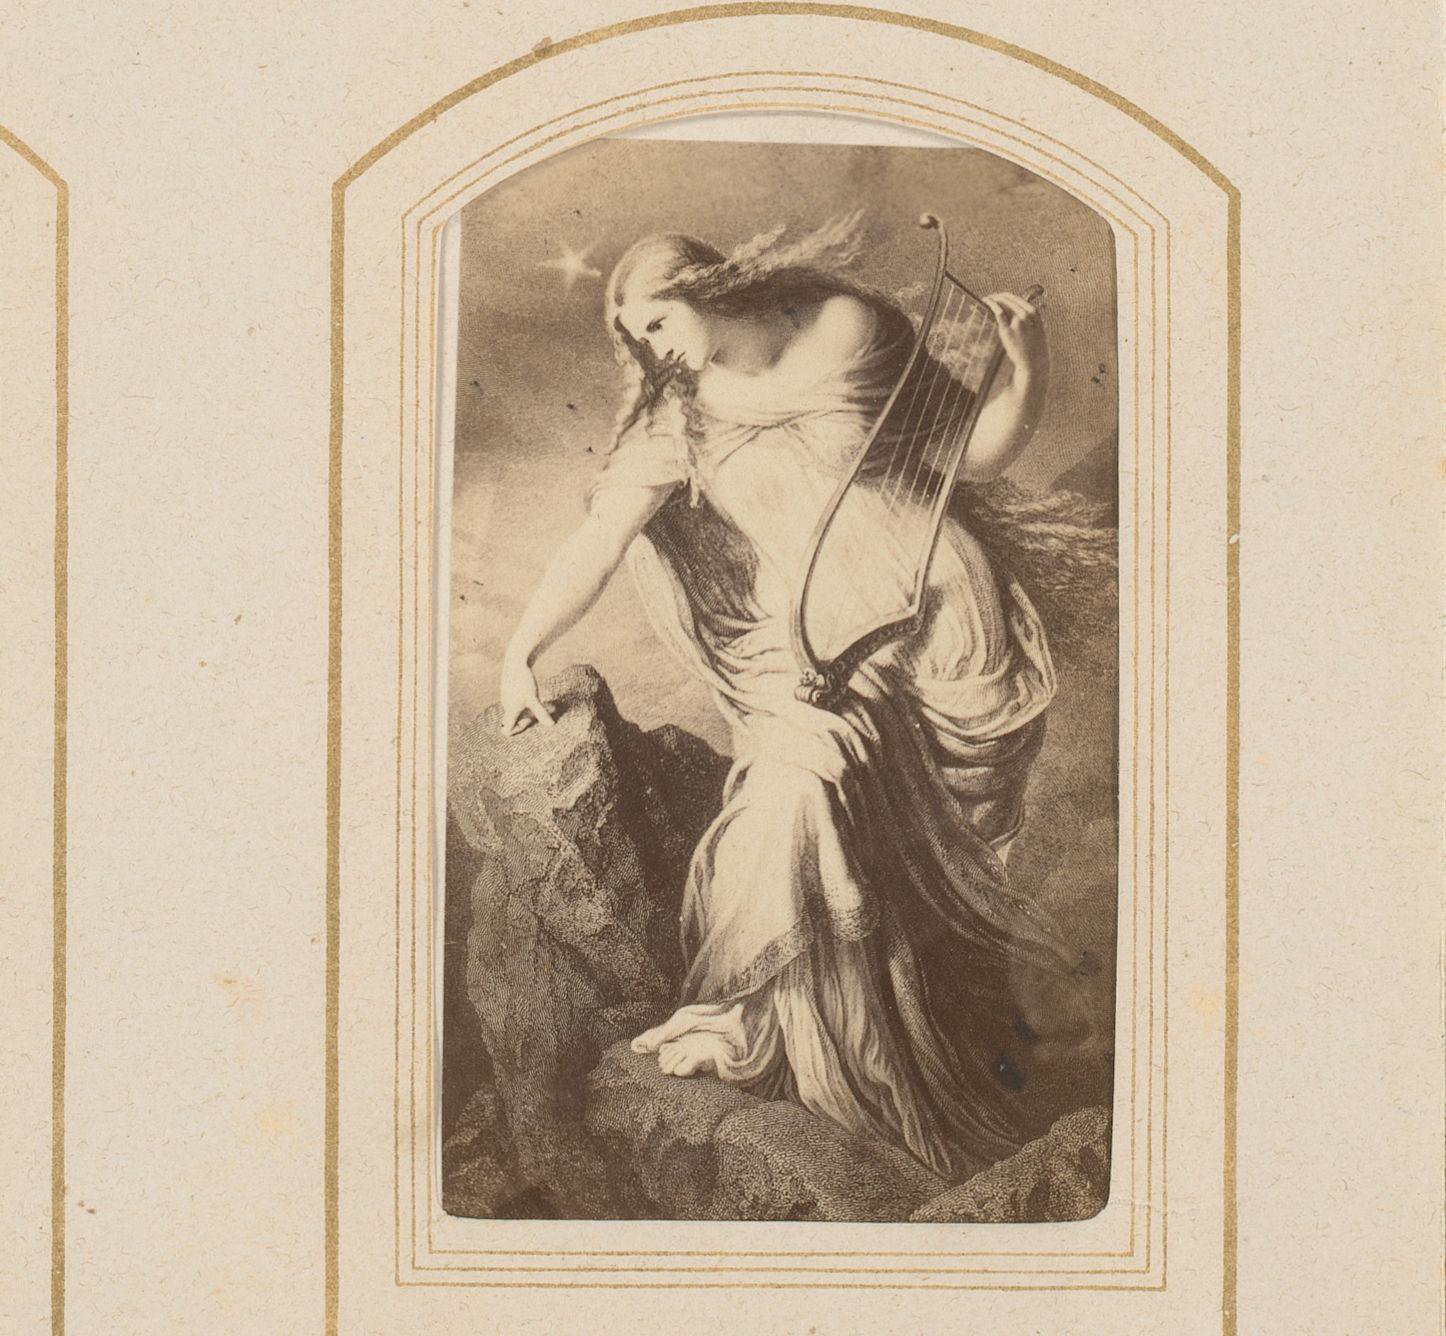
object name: album leaf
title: Fotoreproductie van Loreley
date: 1870-1890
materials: cardboard, photographic support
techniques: albumen print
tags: painting, drawing and the graphic arts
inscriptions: annotation: ‘Loreley’, inscription: ‘[...]’